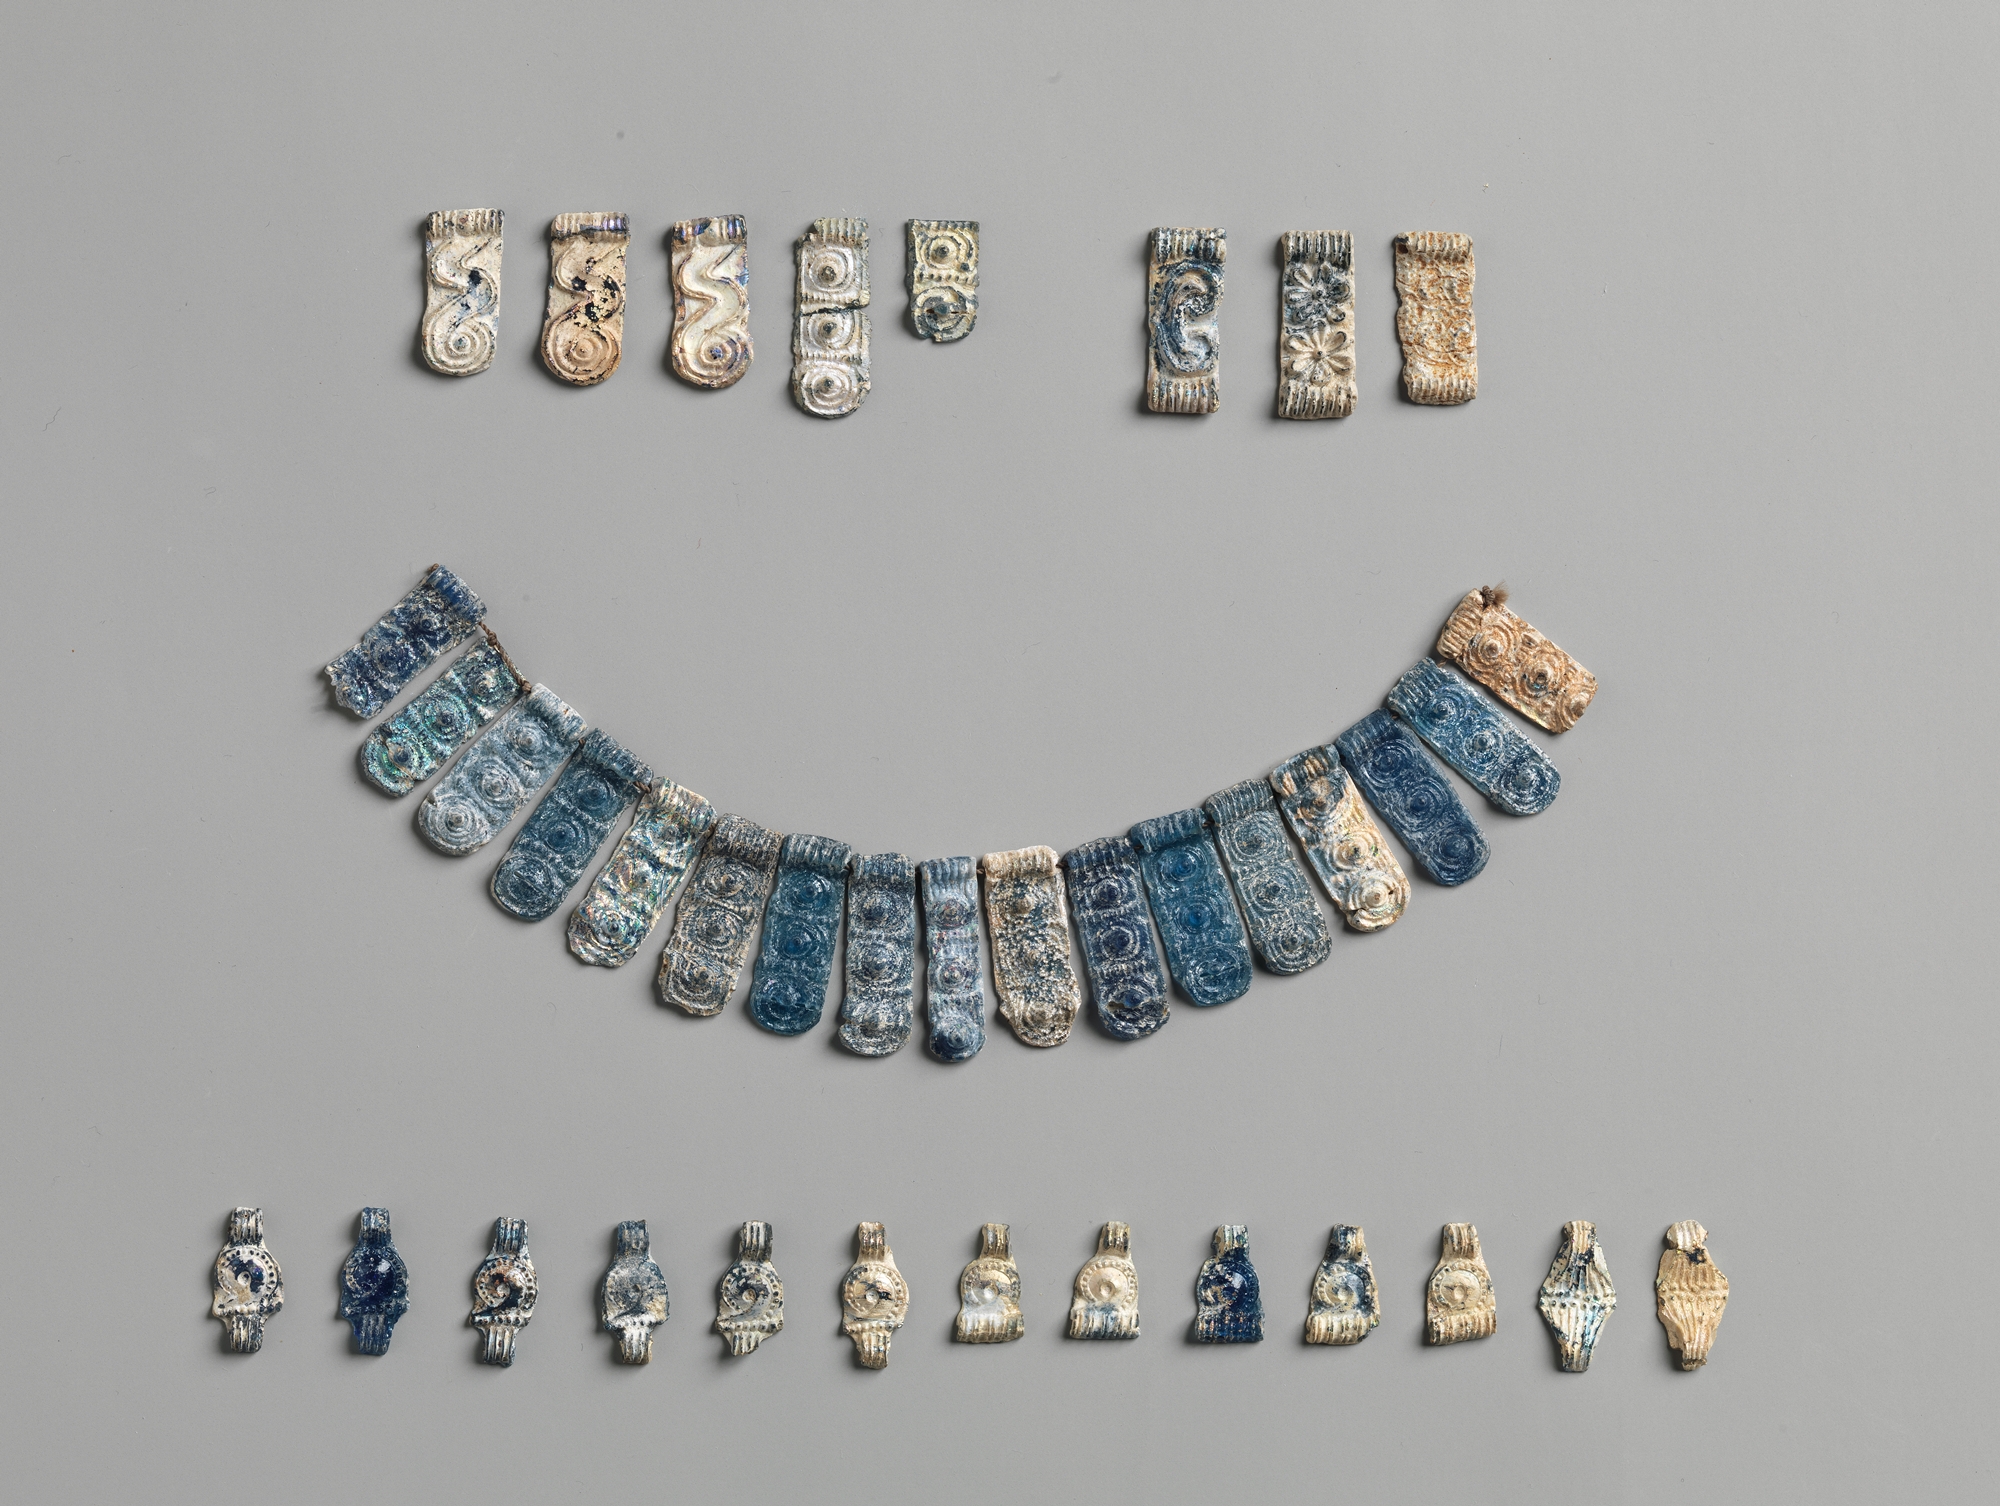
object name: ornament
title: Glass ornament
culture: aegean, helladic or mycenaean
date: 1370-1200 BCE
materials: glass